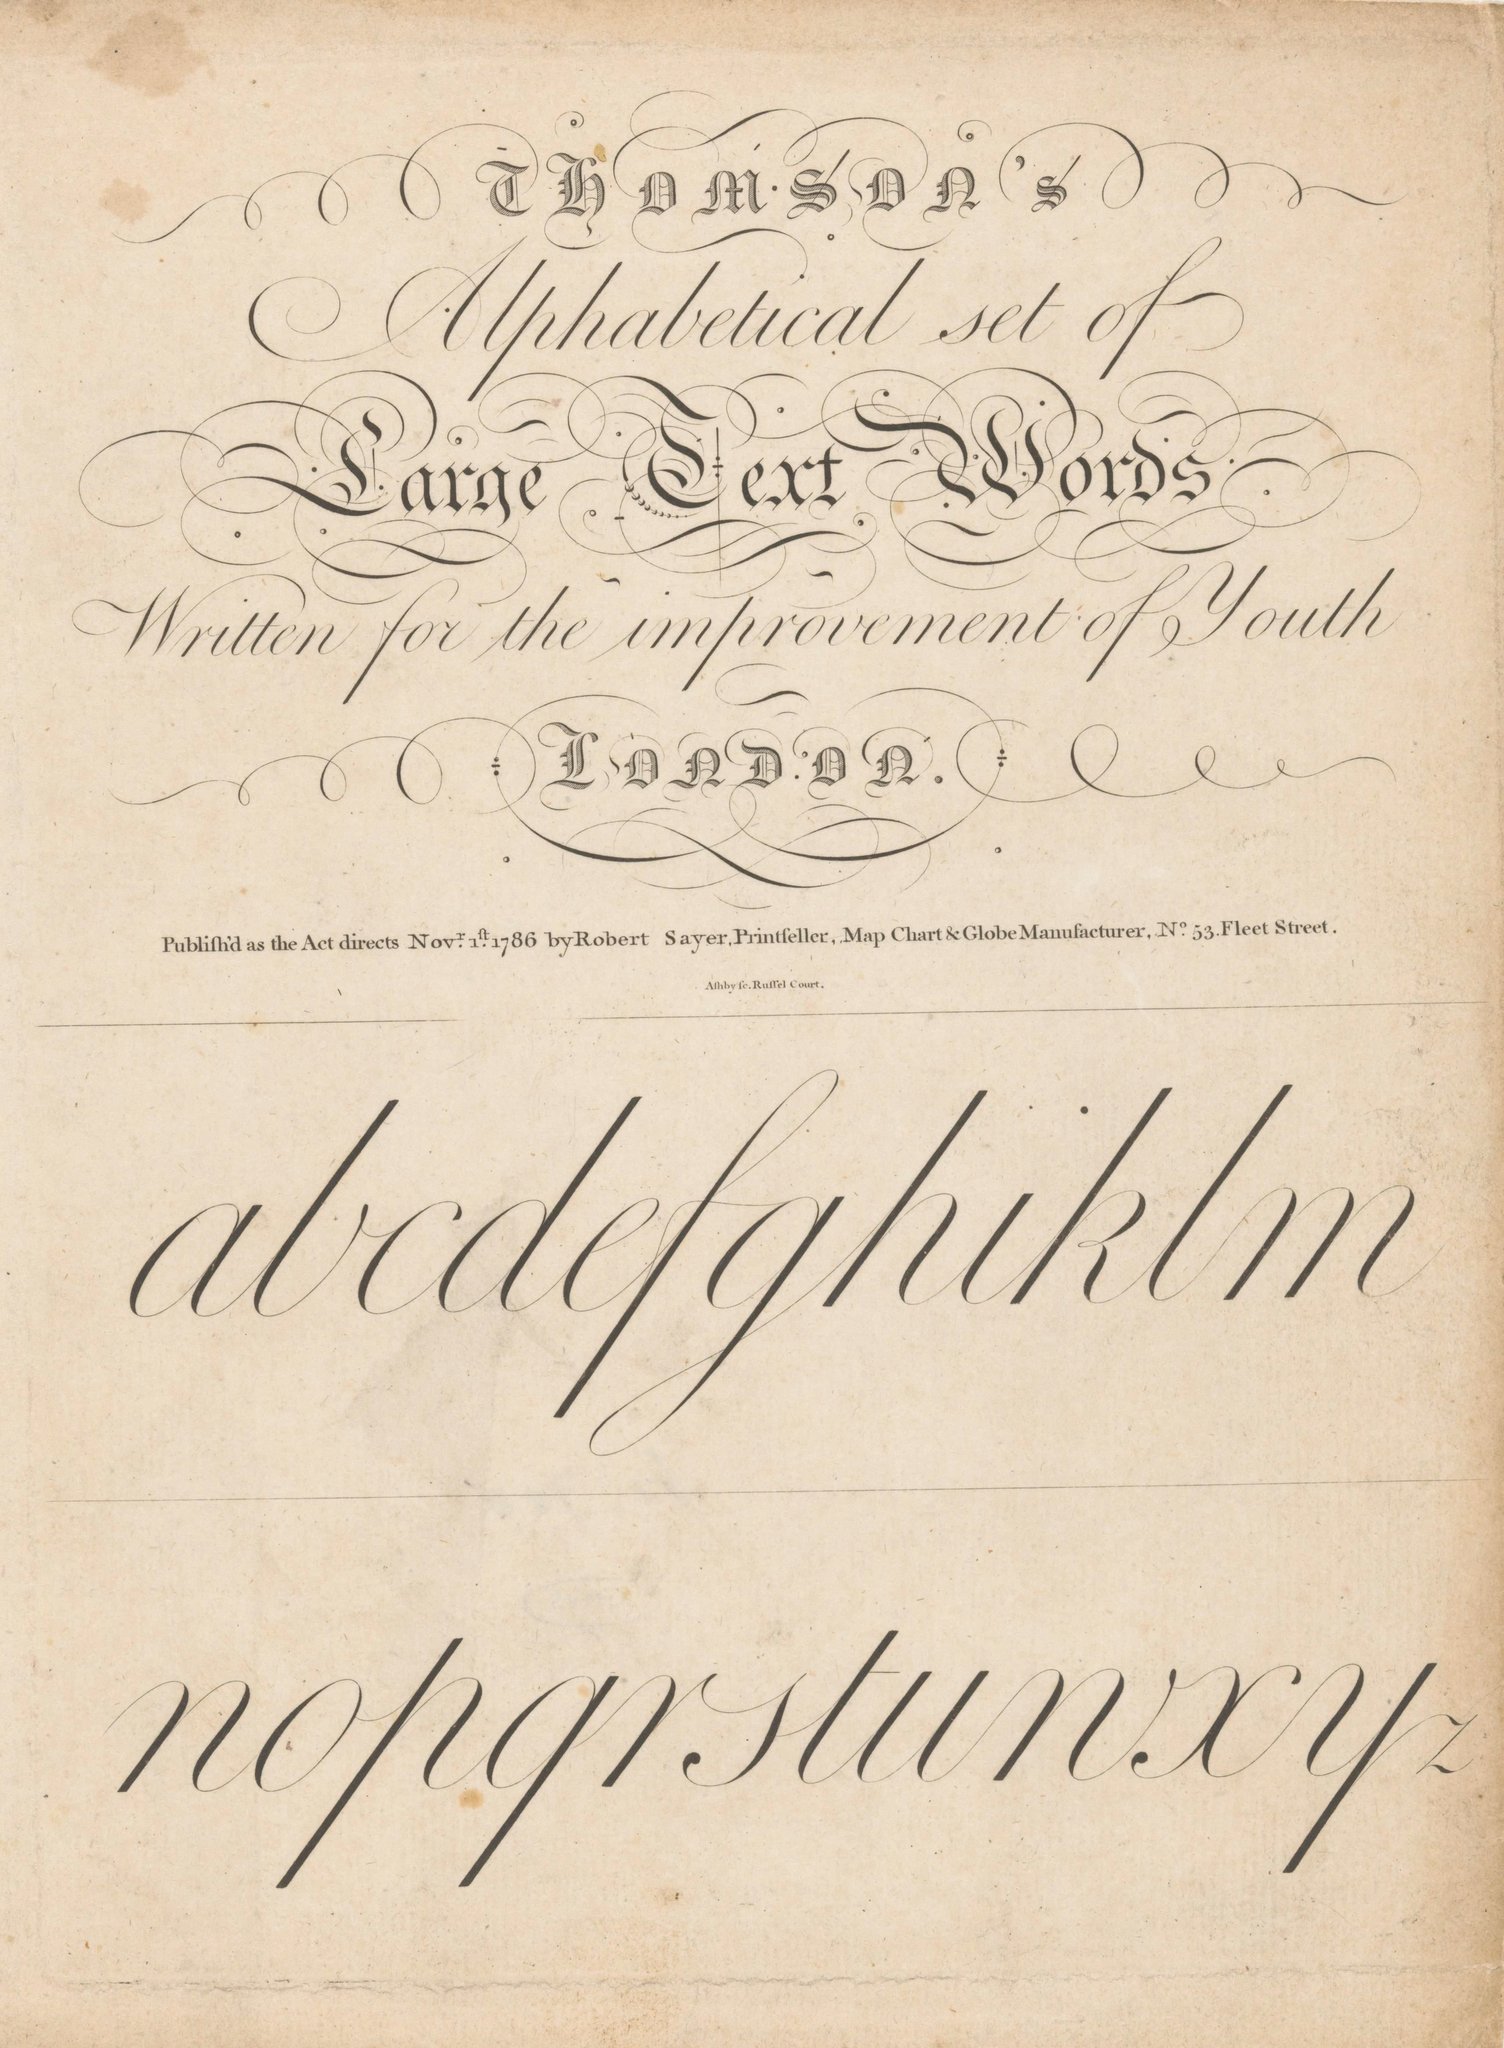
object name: print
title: Lettervoorbeelden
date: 1786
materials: paper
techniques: engraving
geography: london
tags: letters, alphabet, script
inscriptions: collector's mark: Lugt 2228